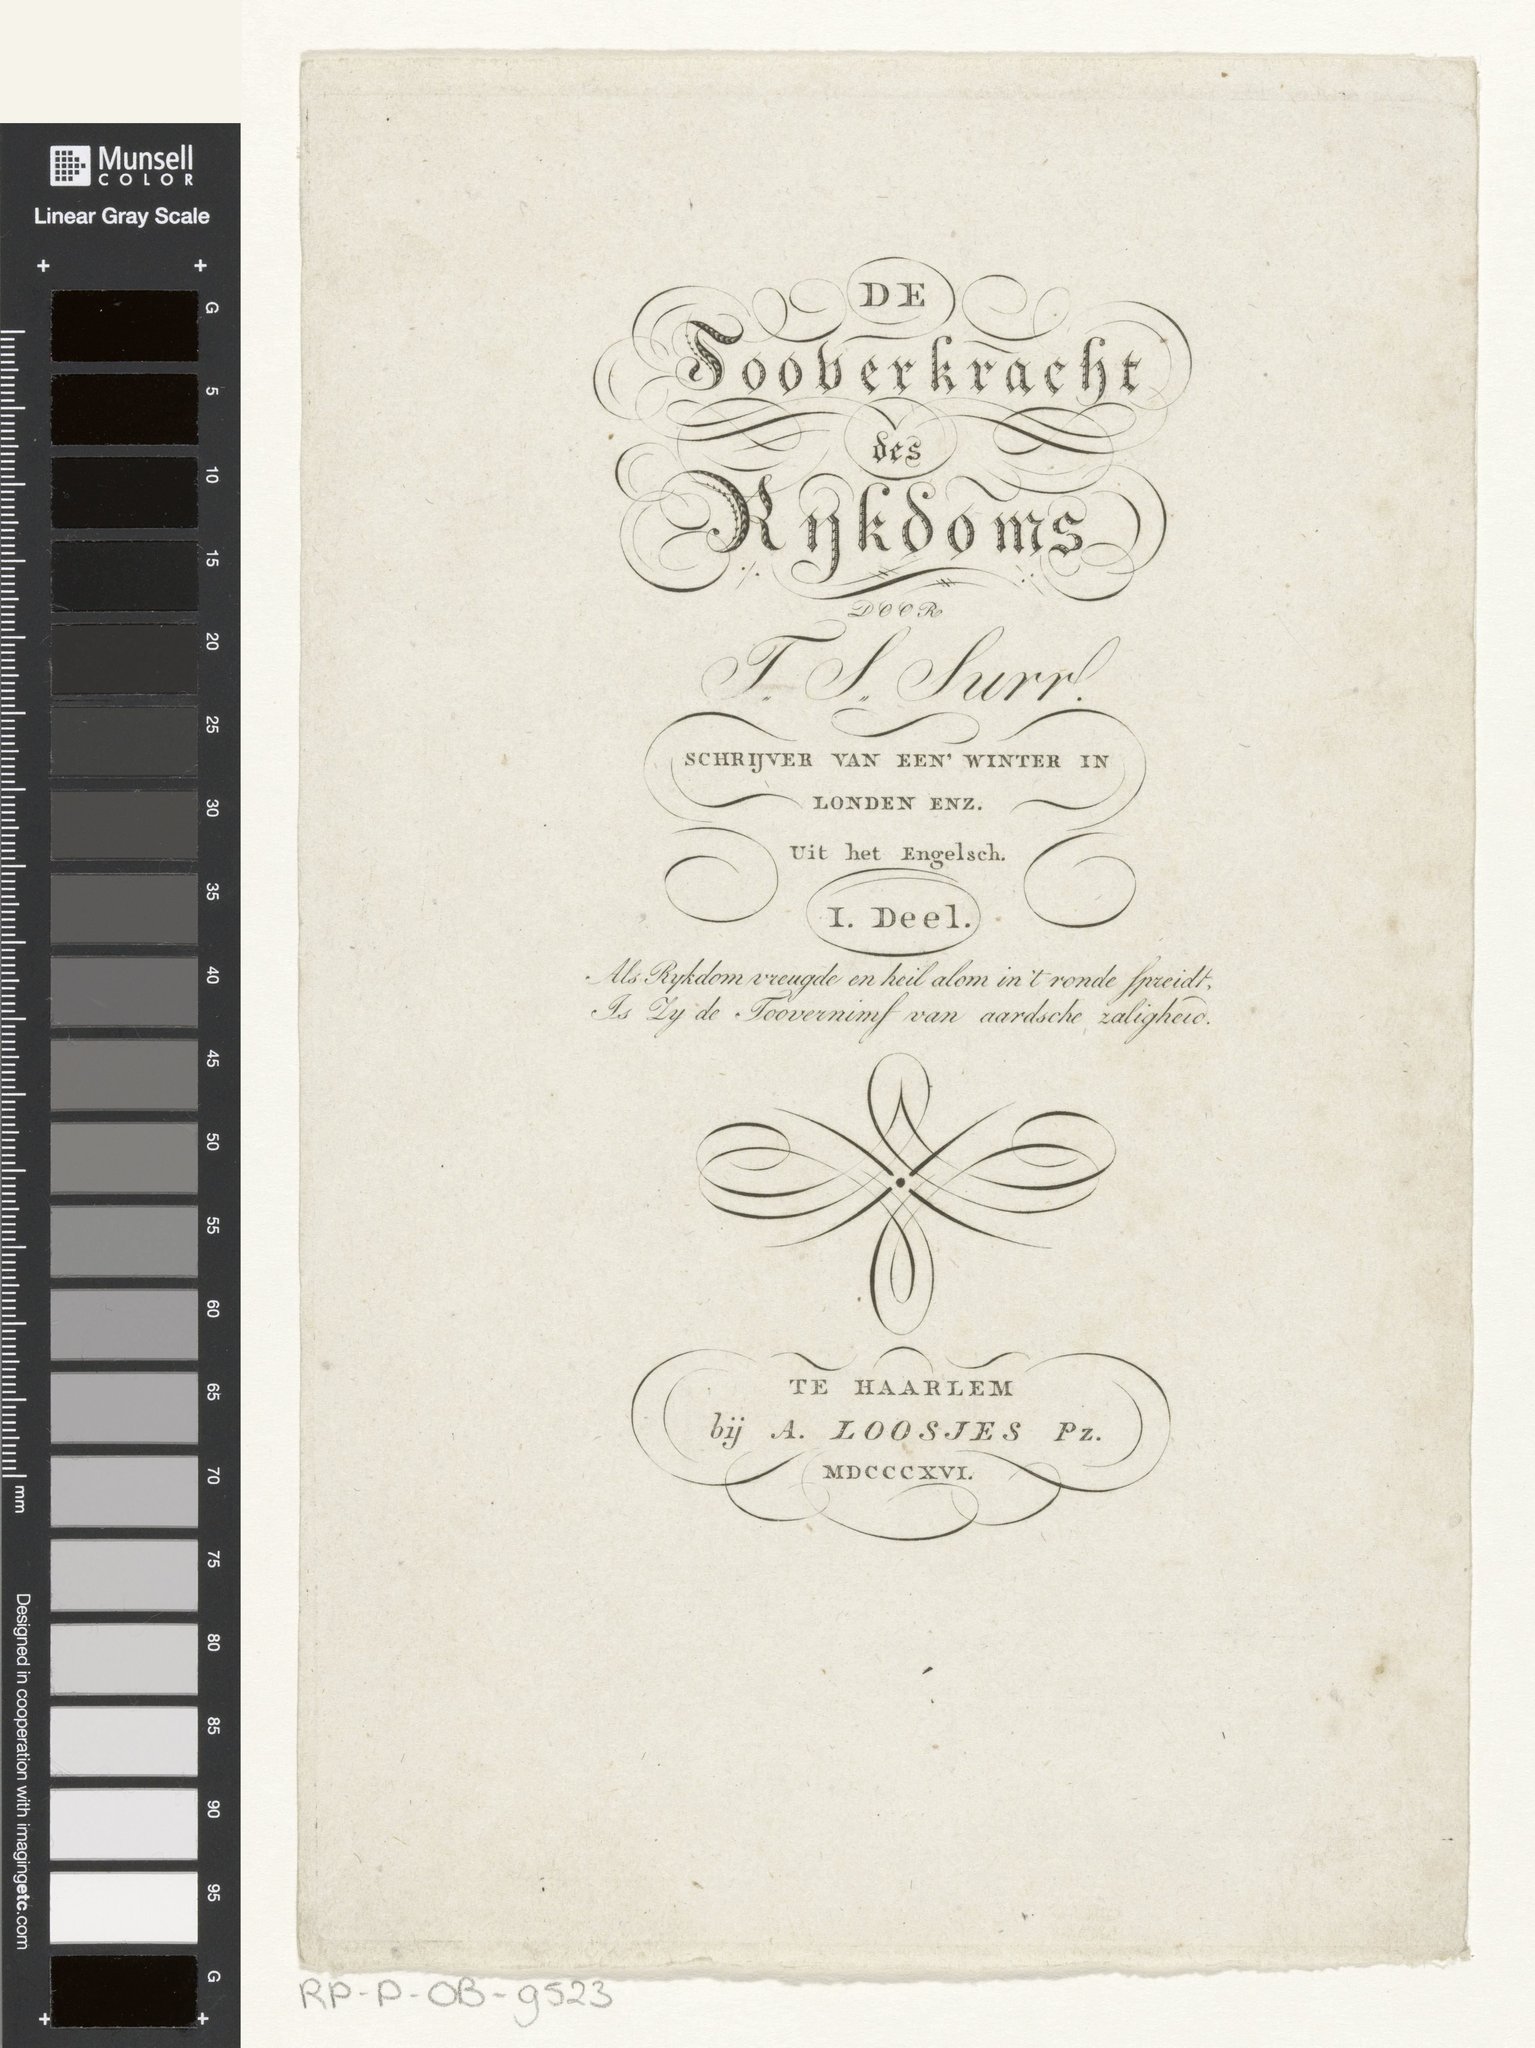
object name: titelblad, titelpagina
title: Titelpagina voor: T.S. Surr, De Tooverkracht des Rijkdoms, 1816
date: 1816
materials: paper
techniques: engraving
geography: haarlem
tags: title-page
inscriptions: collector's mark: Lugt 2228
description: Titelpagina voor: Surr, T.S. De Tooverkracht des Rijkdoms, I. Deel. Haarlem: Loosjes, Adriaan Pietersz., 1816.